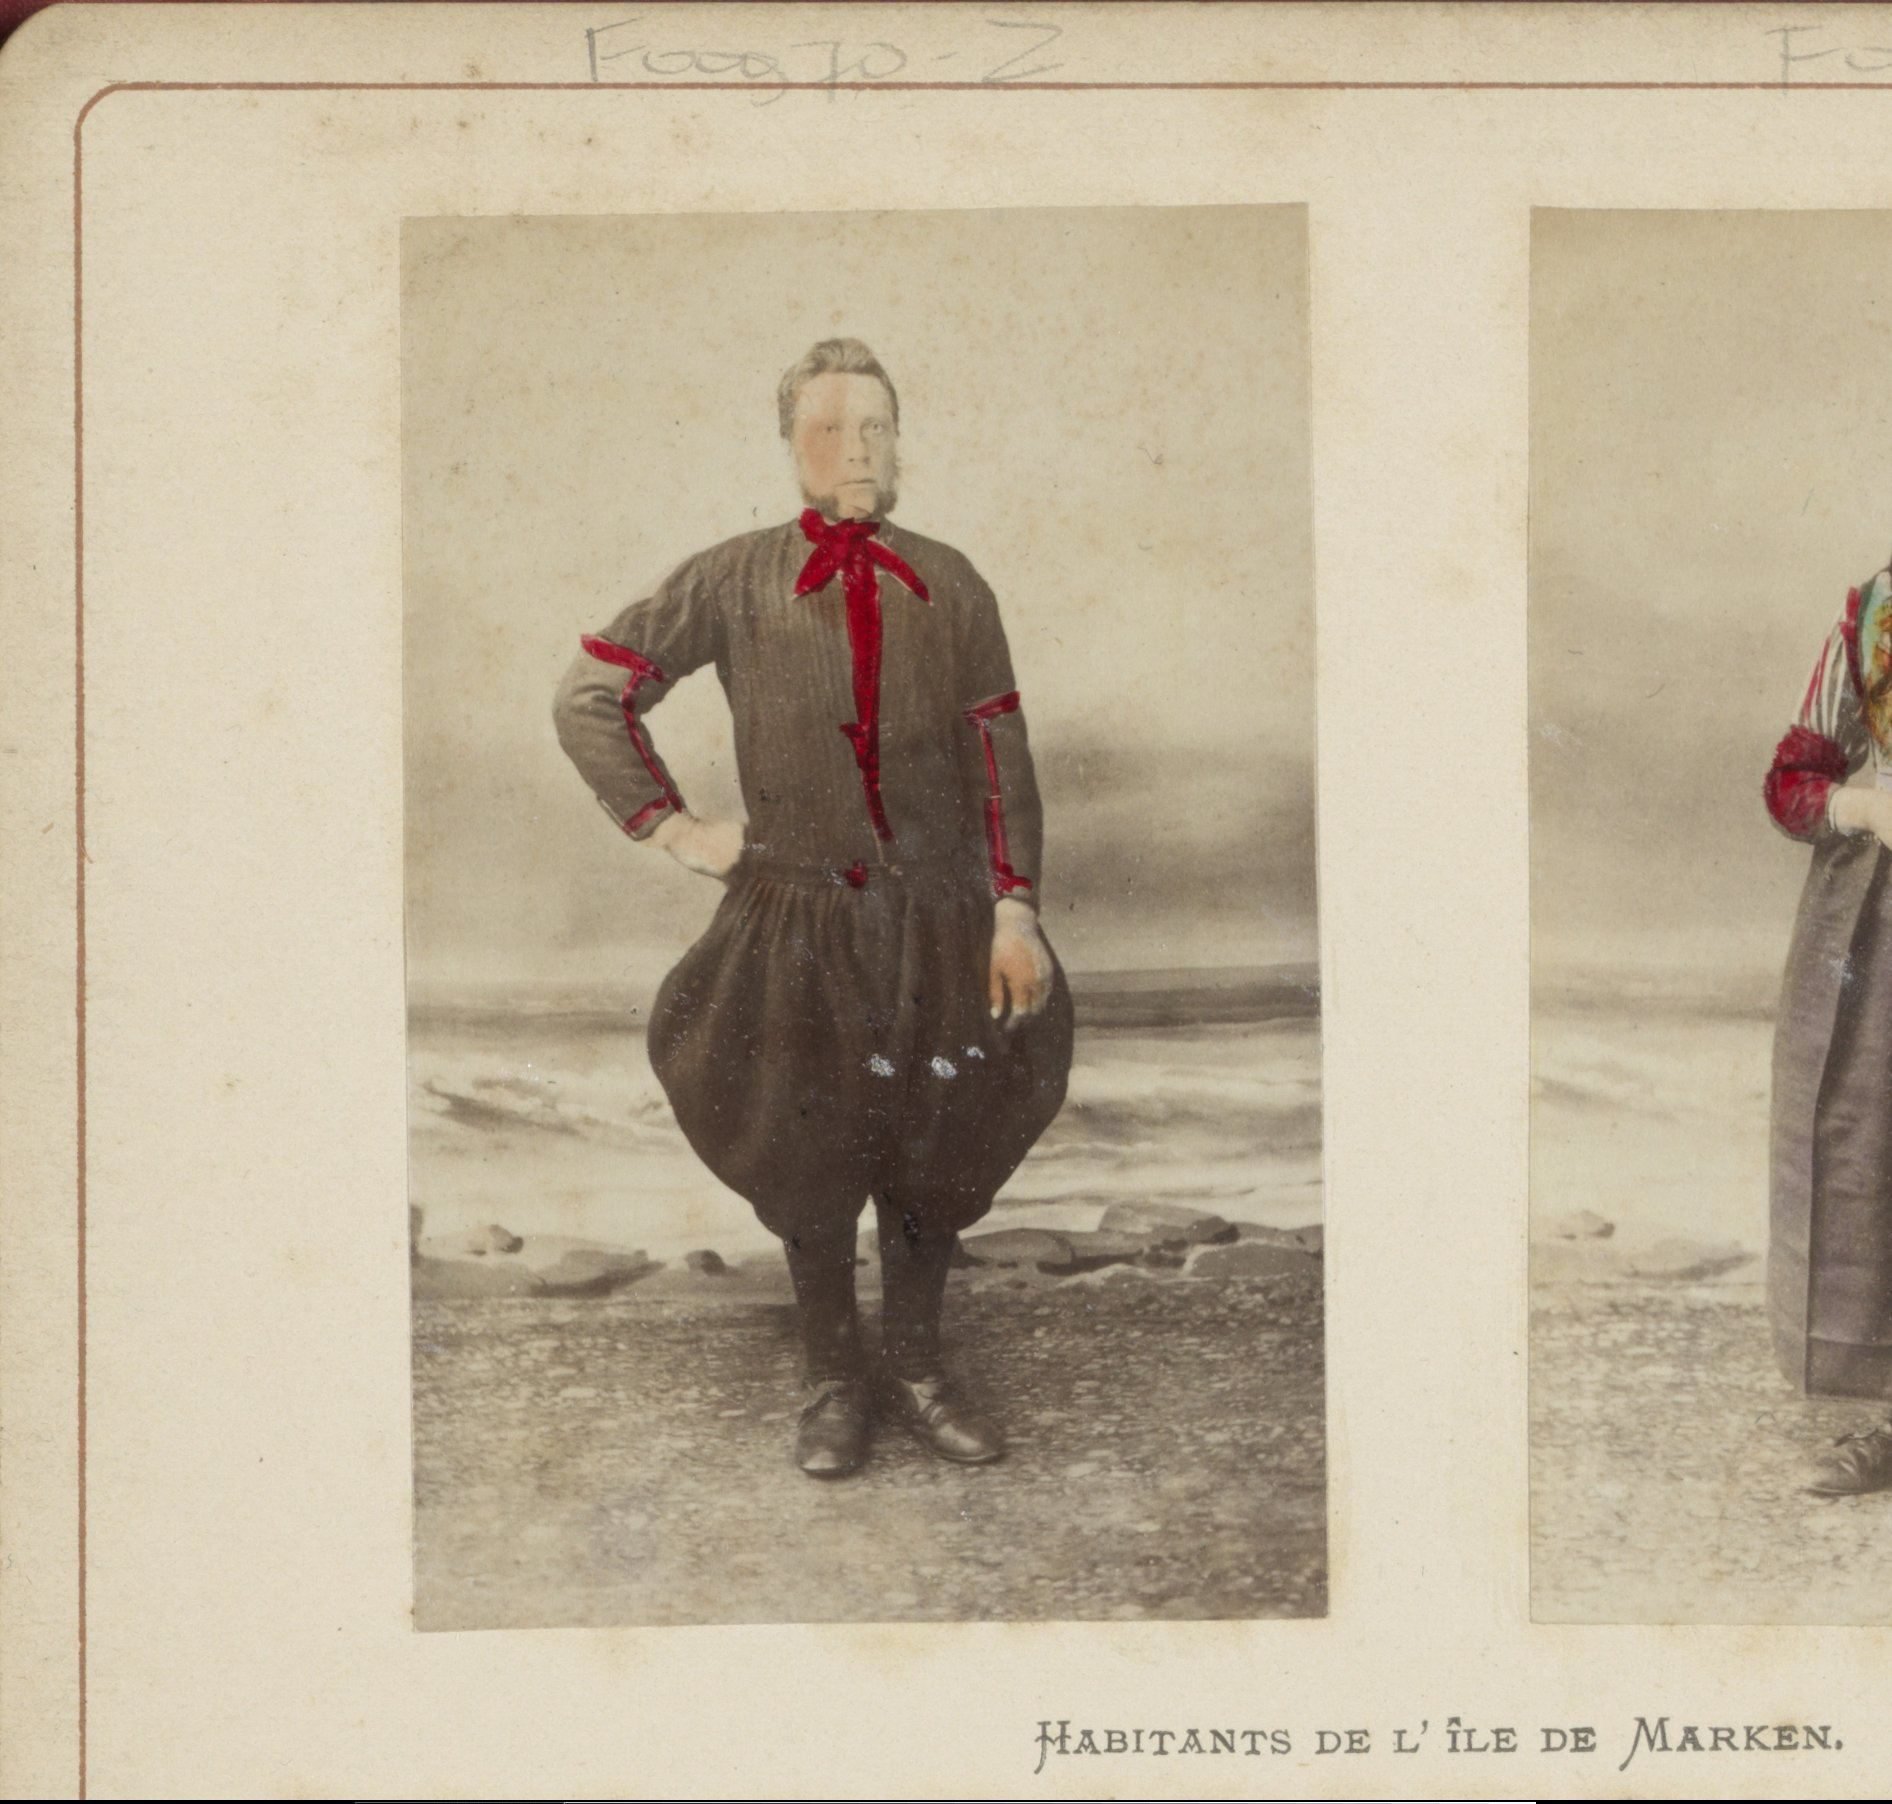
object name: photograph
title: Portret van een man in de klederdracht van Marken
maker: andries jager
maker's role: publisher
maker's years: 1825-1905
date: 1878-1890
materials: cardboard, paper, photographic support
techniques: albumen print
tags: studio requisites ~ photographer, historical persons, shoes, sandals, folk costume, regional costume, fisherman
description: Onderdeel van Leporelloalbum met 28 foto's van Amsterdam en omstreken.